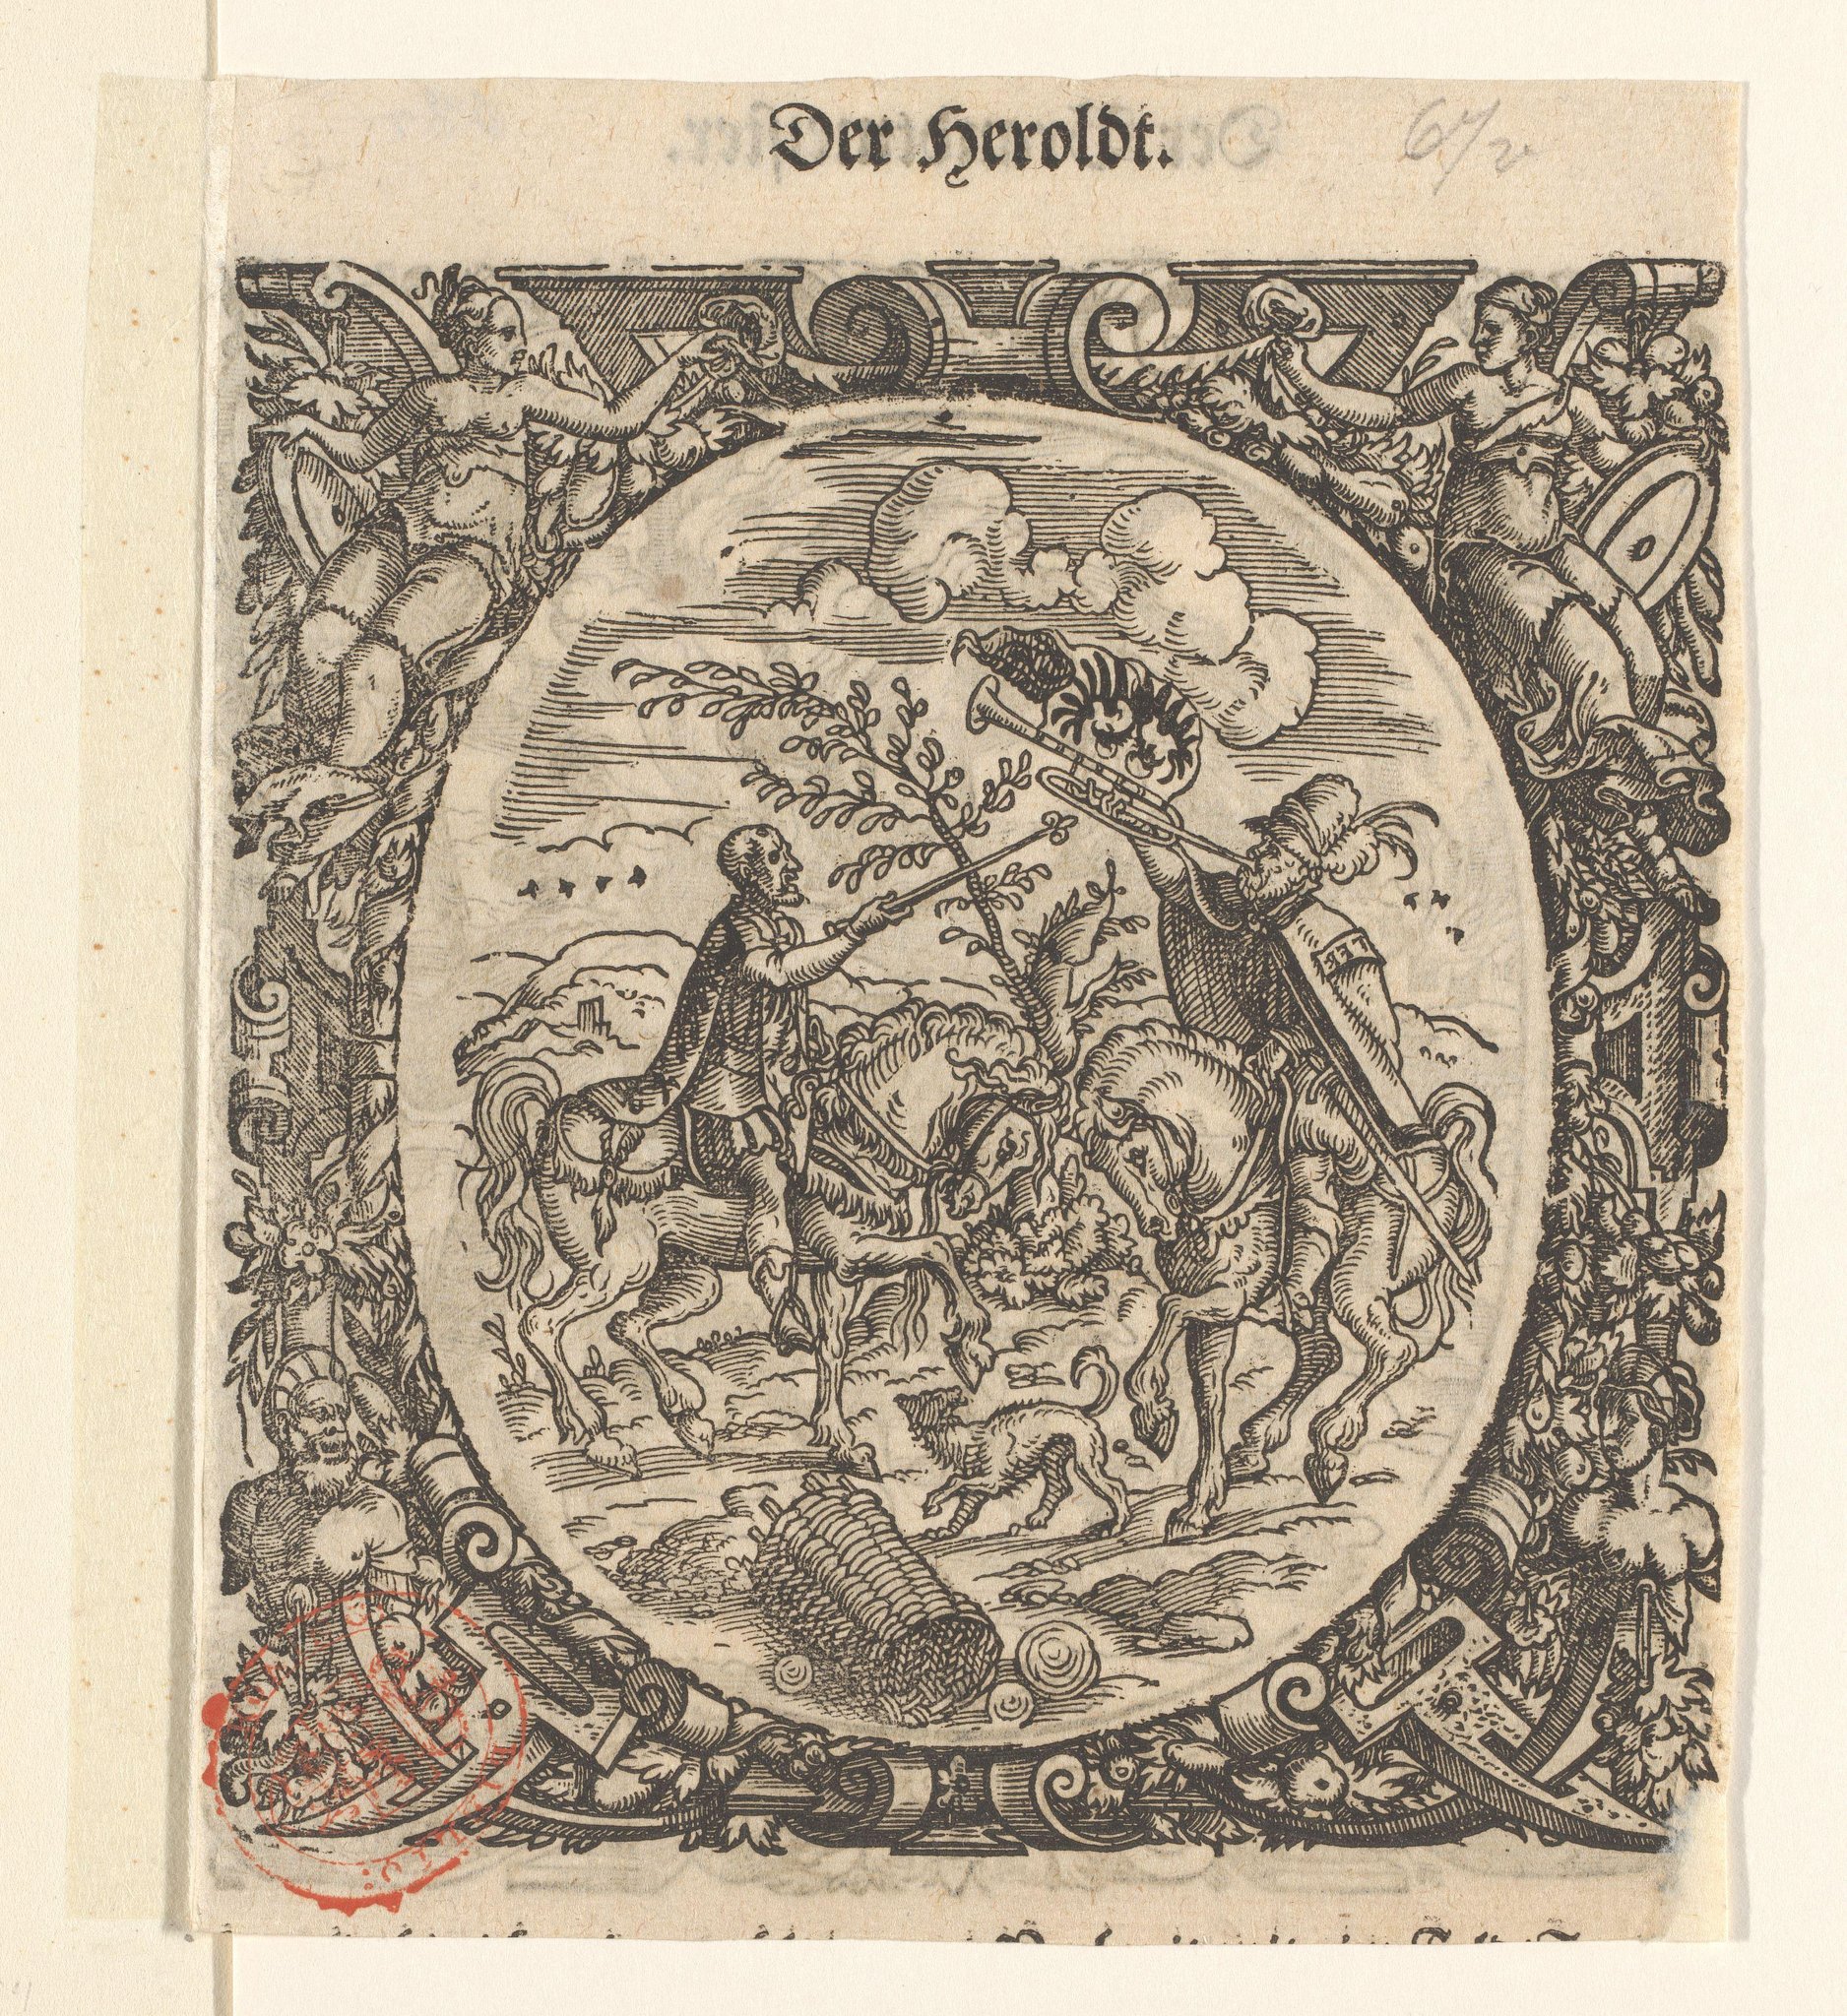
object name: print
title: Der heroldt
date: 1573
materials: paper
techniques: woodcut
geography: frankfurt am main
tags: warfare; military affairs, the soldier; the soldier's life, herald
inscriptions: collector's mark: Lugt 240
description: Zowel de voorstelling als de ornamentrand werd gebruikt voor verschillende edities van Leonhardt Fronspergers Kriegsbuch.